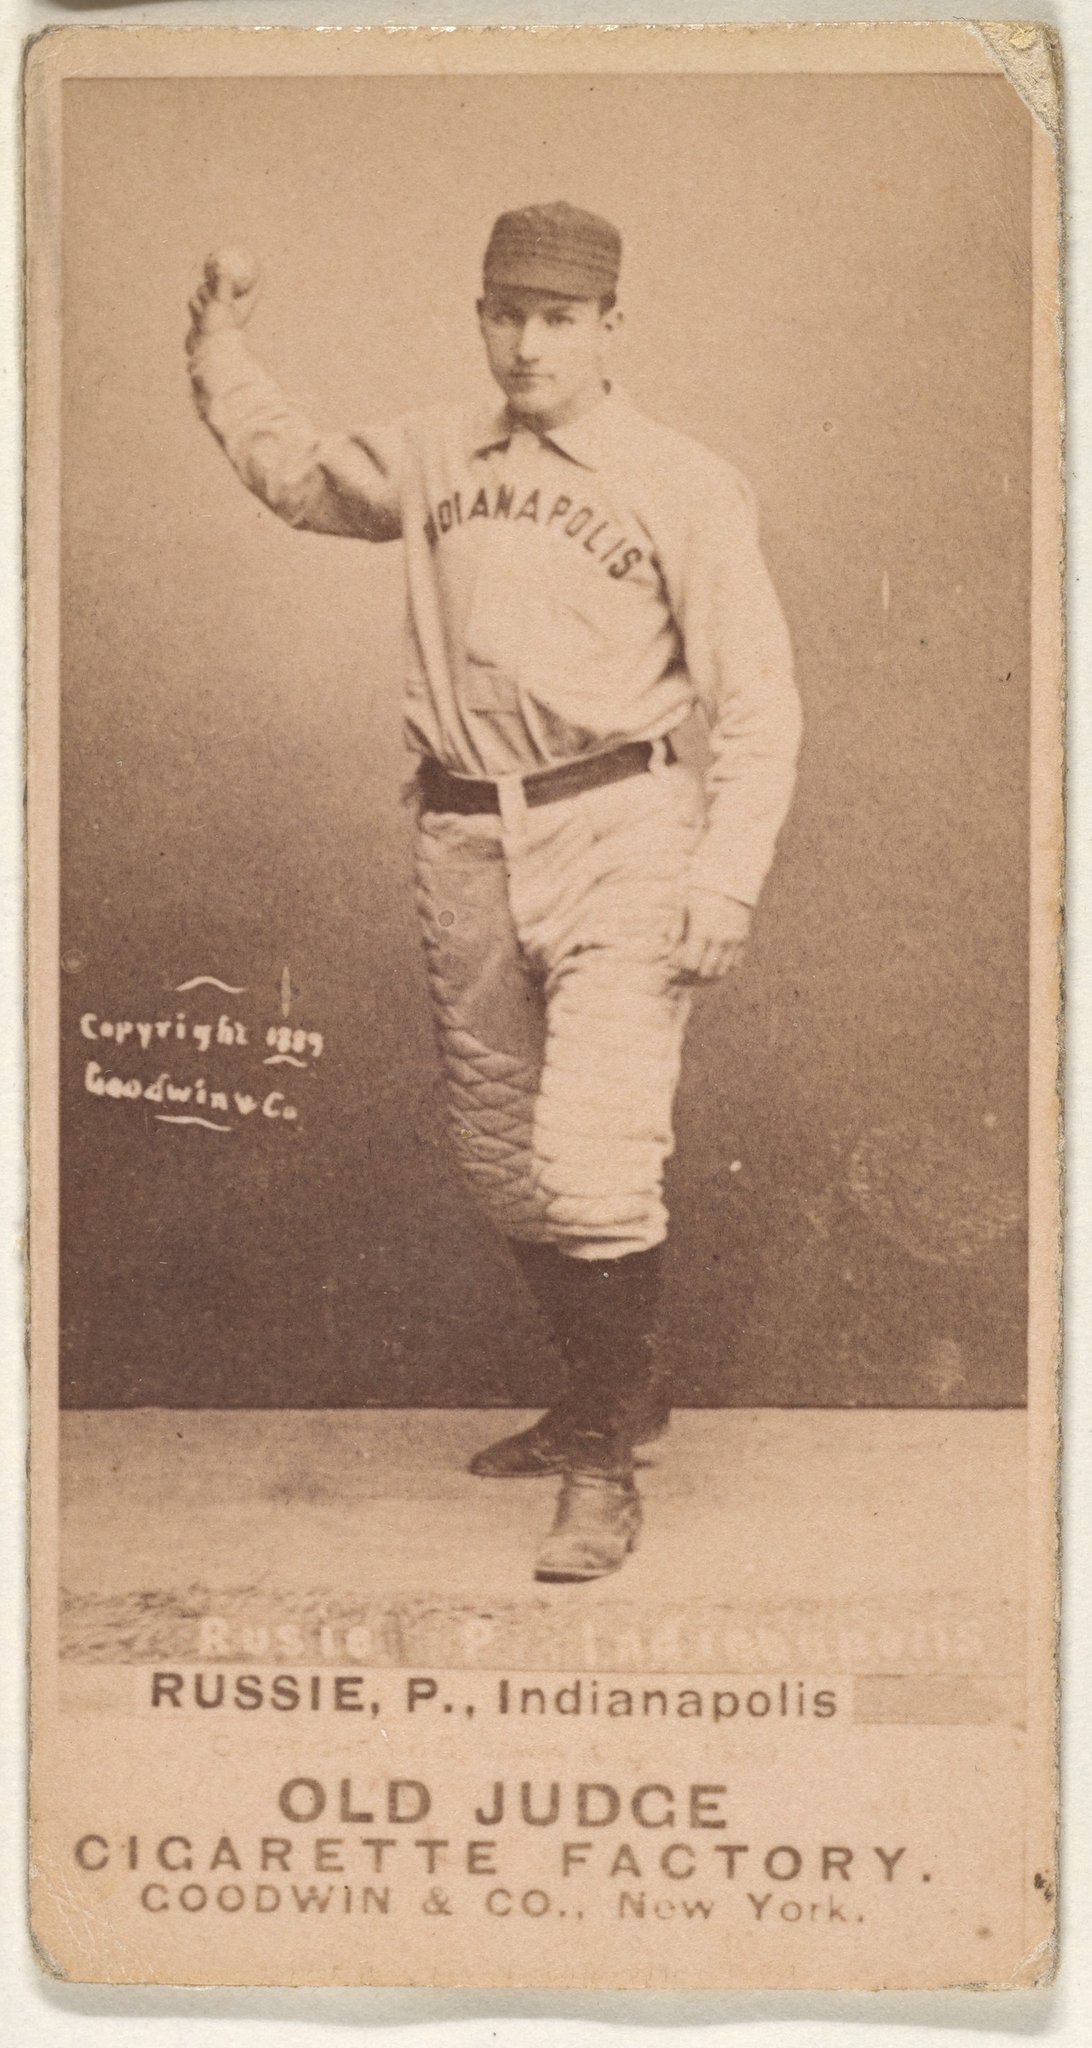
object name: baseball card, photograph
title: Amos Rusie, Pitcher, Indianapolis, from the Old Judge series (N172) for Old Judge Cigarettes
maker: goodwin & company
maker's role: publisher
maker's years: 1850-1950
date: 1887-1890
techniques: albumen silver print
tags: men,baseball,athletes